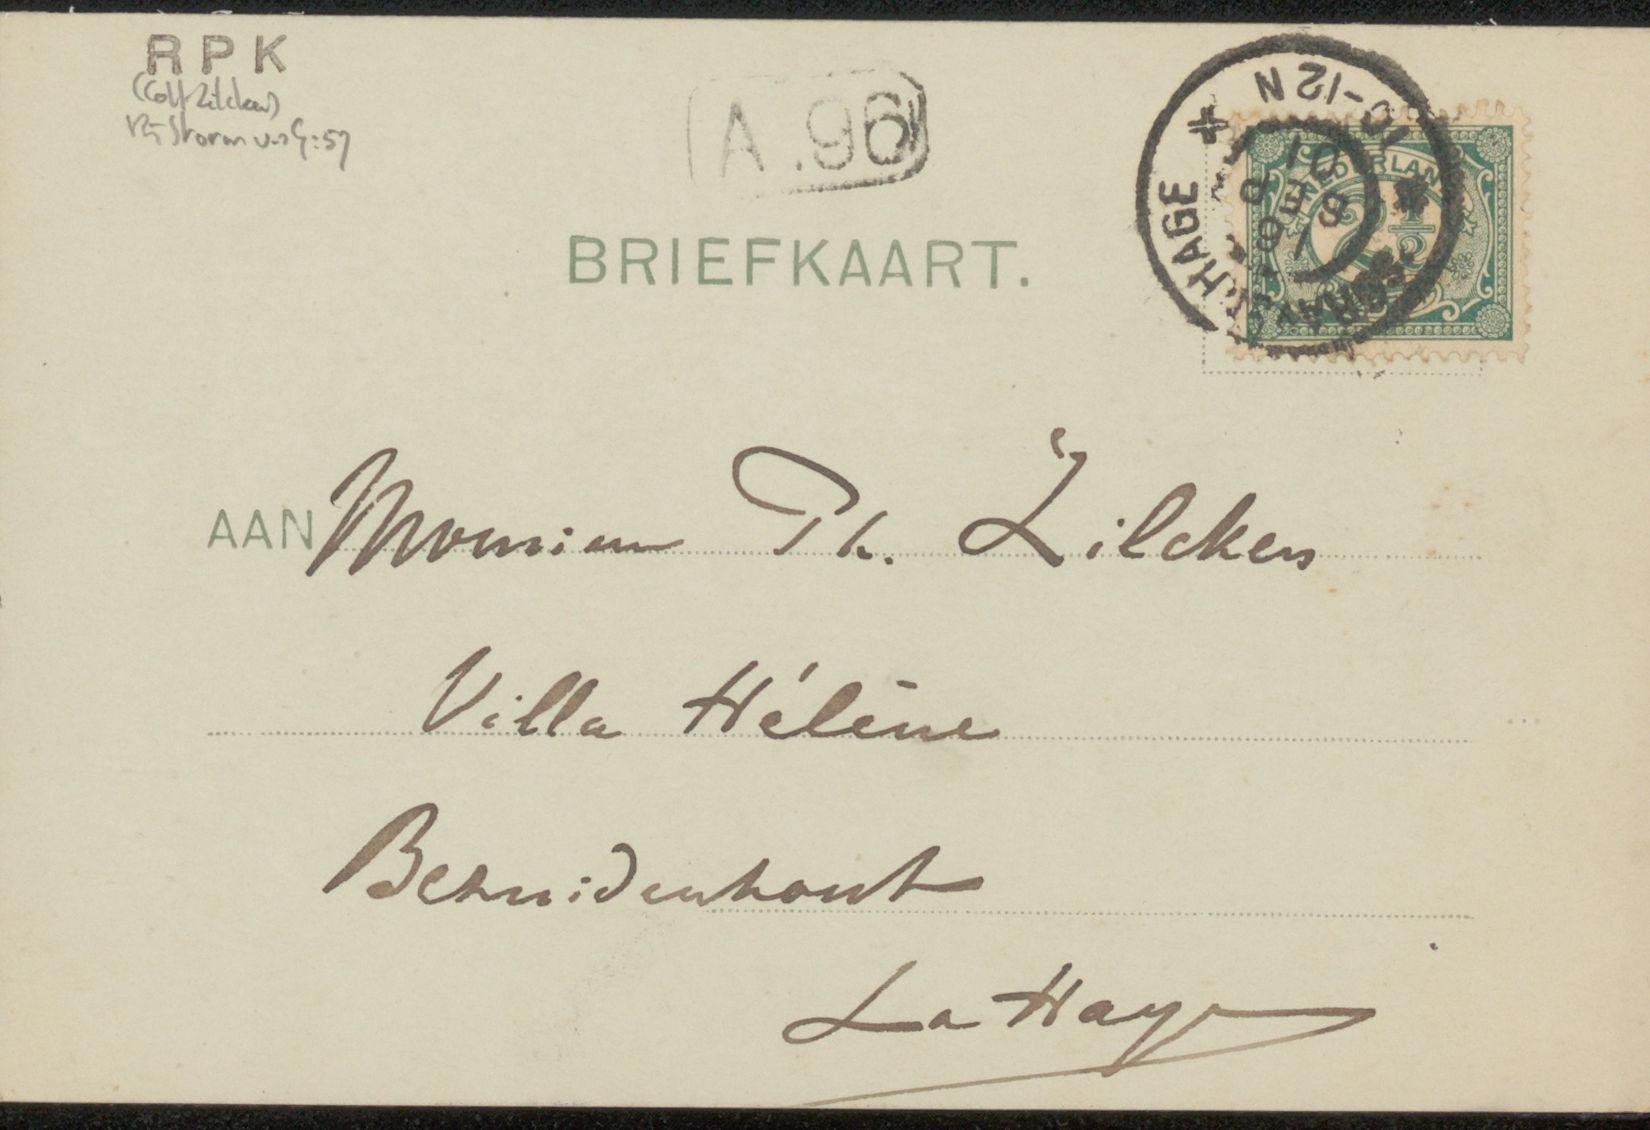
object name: postcard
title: Briefkaart aan Philip Zilcken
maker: carel nicolaas storm van s-gravesande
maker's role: draughtsman, print maker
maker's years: 1841-1924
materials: cardboard, ink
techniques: pen, writing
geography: the hague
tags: the hague, painter, draughtsman, philip zilcken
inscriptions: collector's mark: ‘RPK’